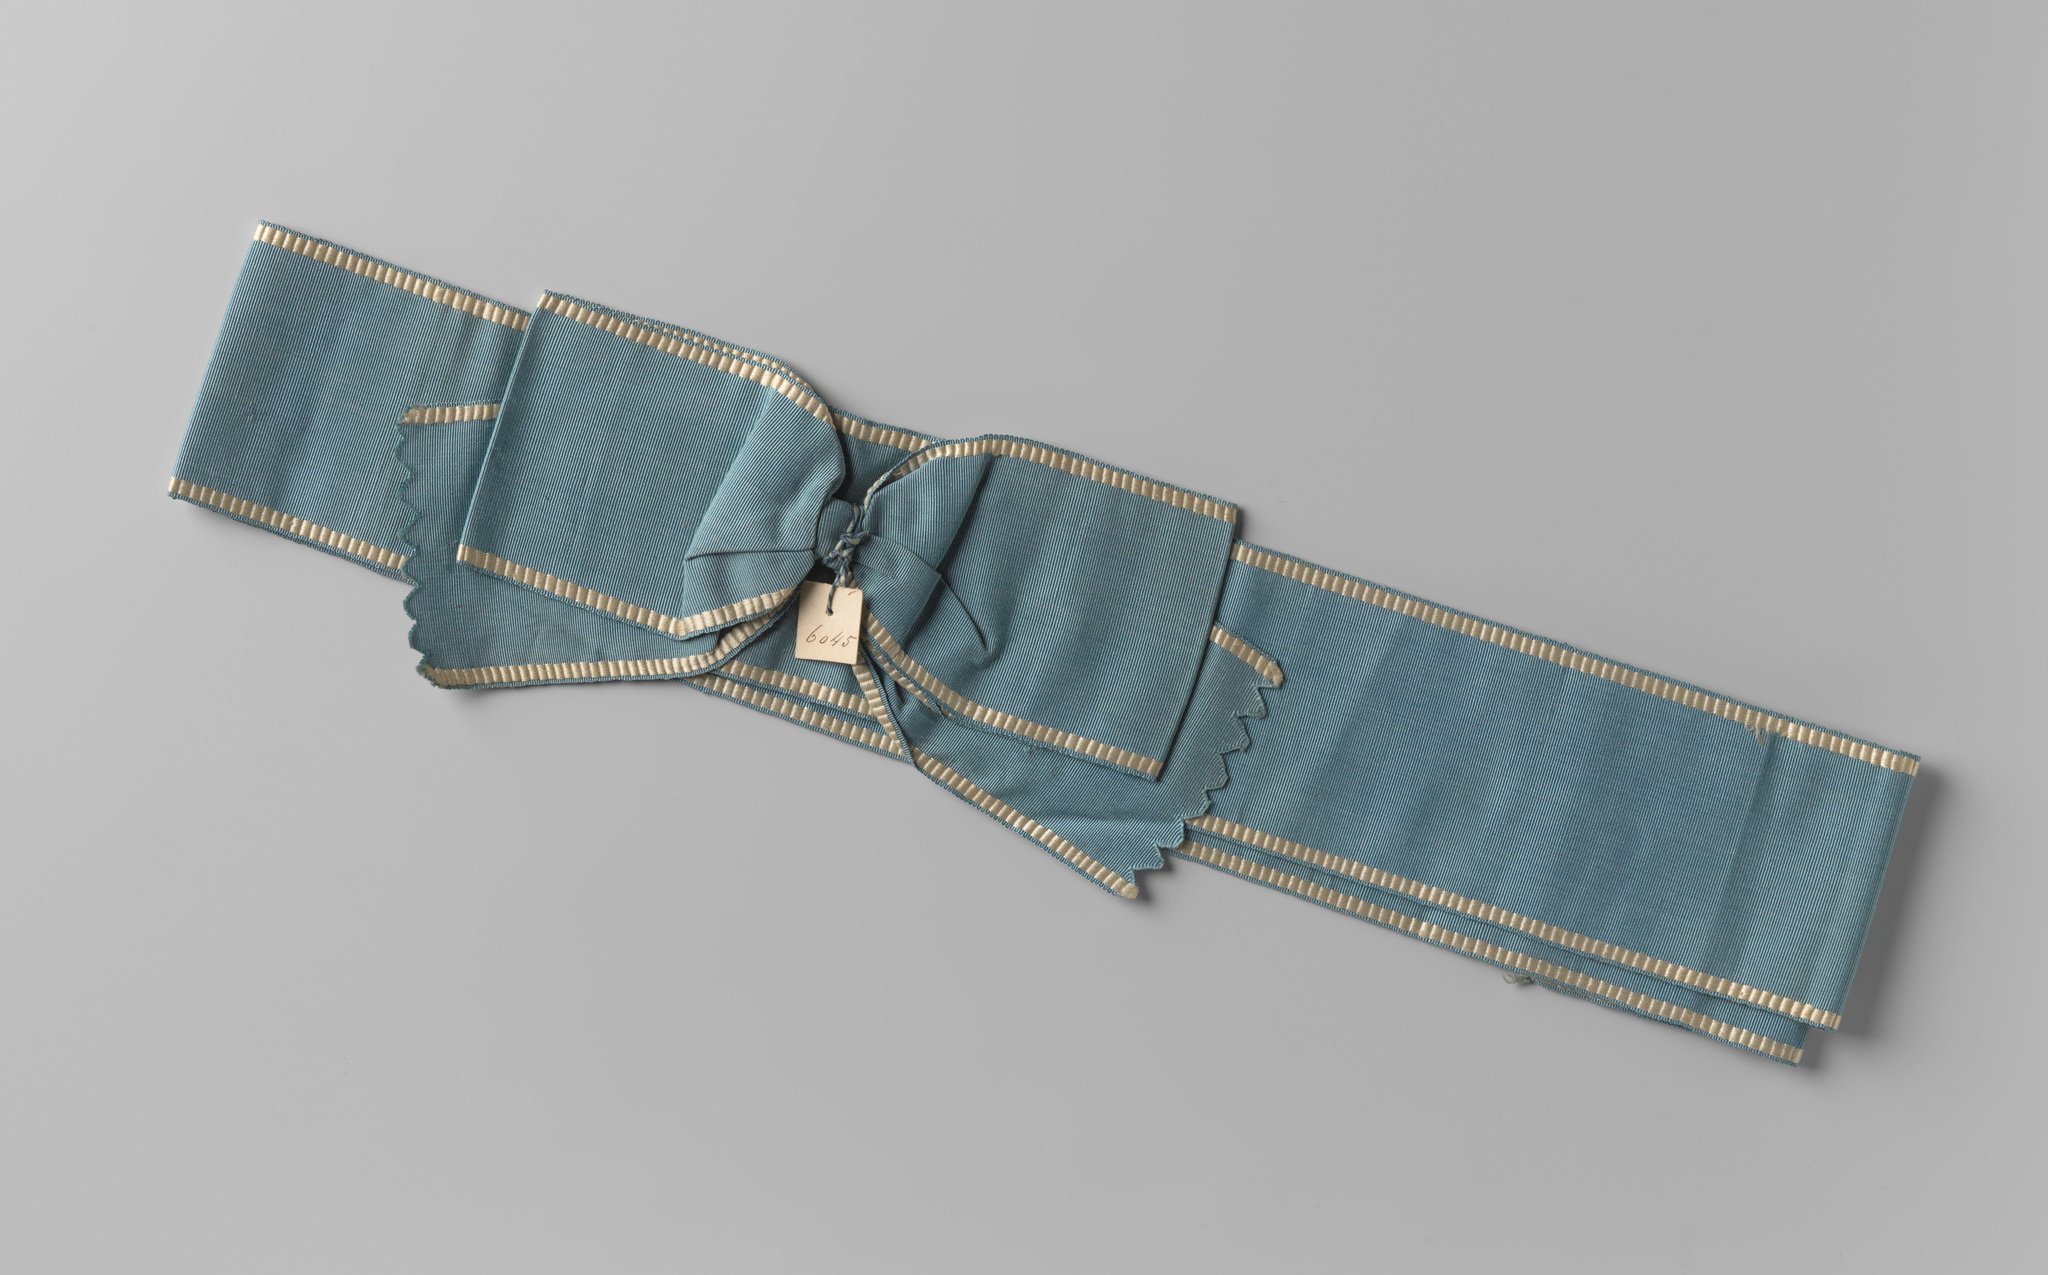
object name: womenswear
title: Lint met strik van blauwe zijde met witte (of verbleekt oranje) biezen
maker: Anonymous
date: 1600-1999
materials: silk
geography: western europe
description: Lint met strik, gemaakt van blauwe zijde dat langs beide lange zijden is afgezet met een witte (of verbleekt oranje) bies.